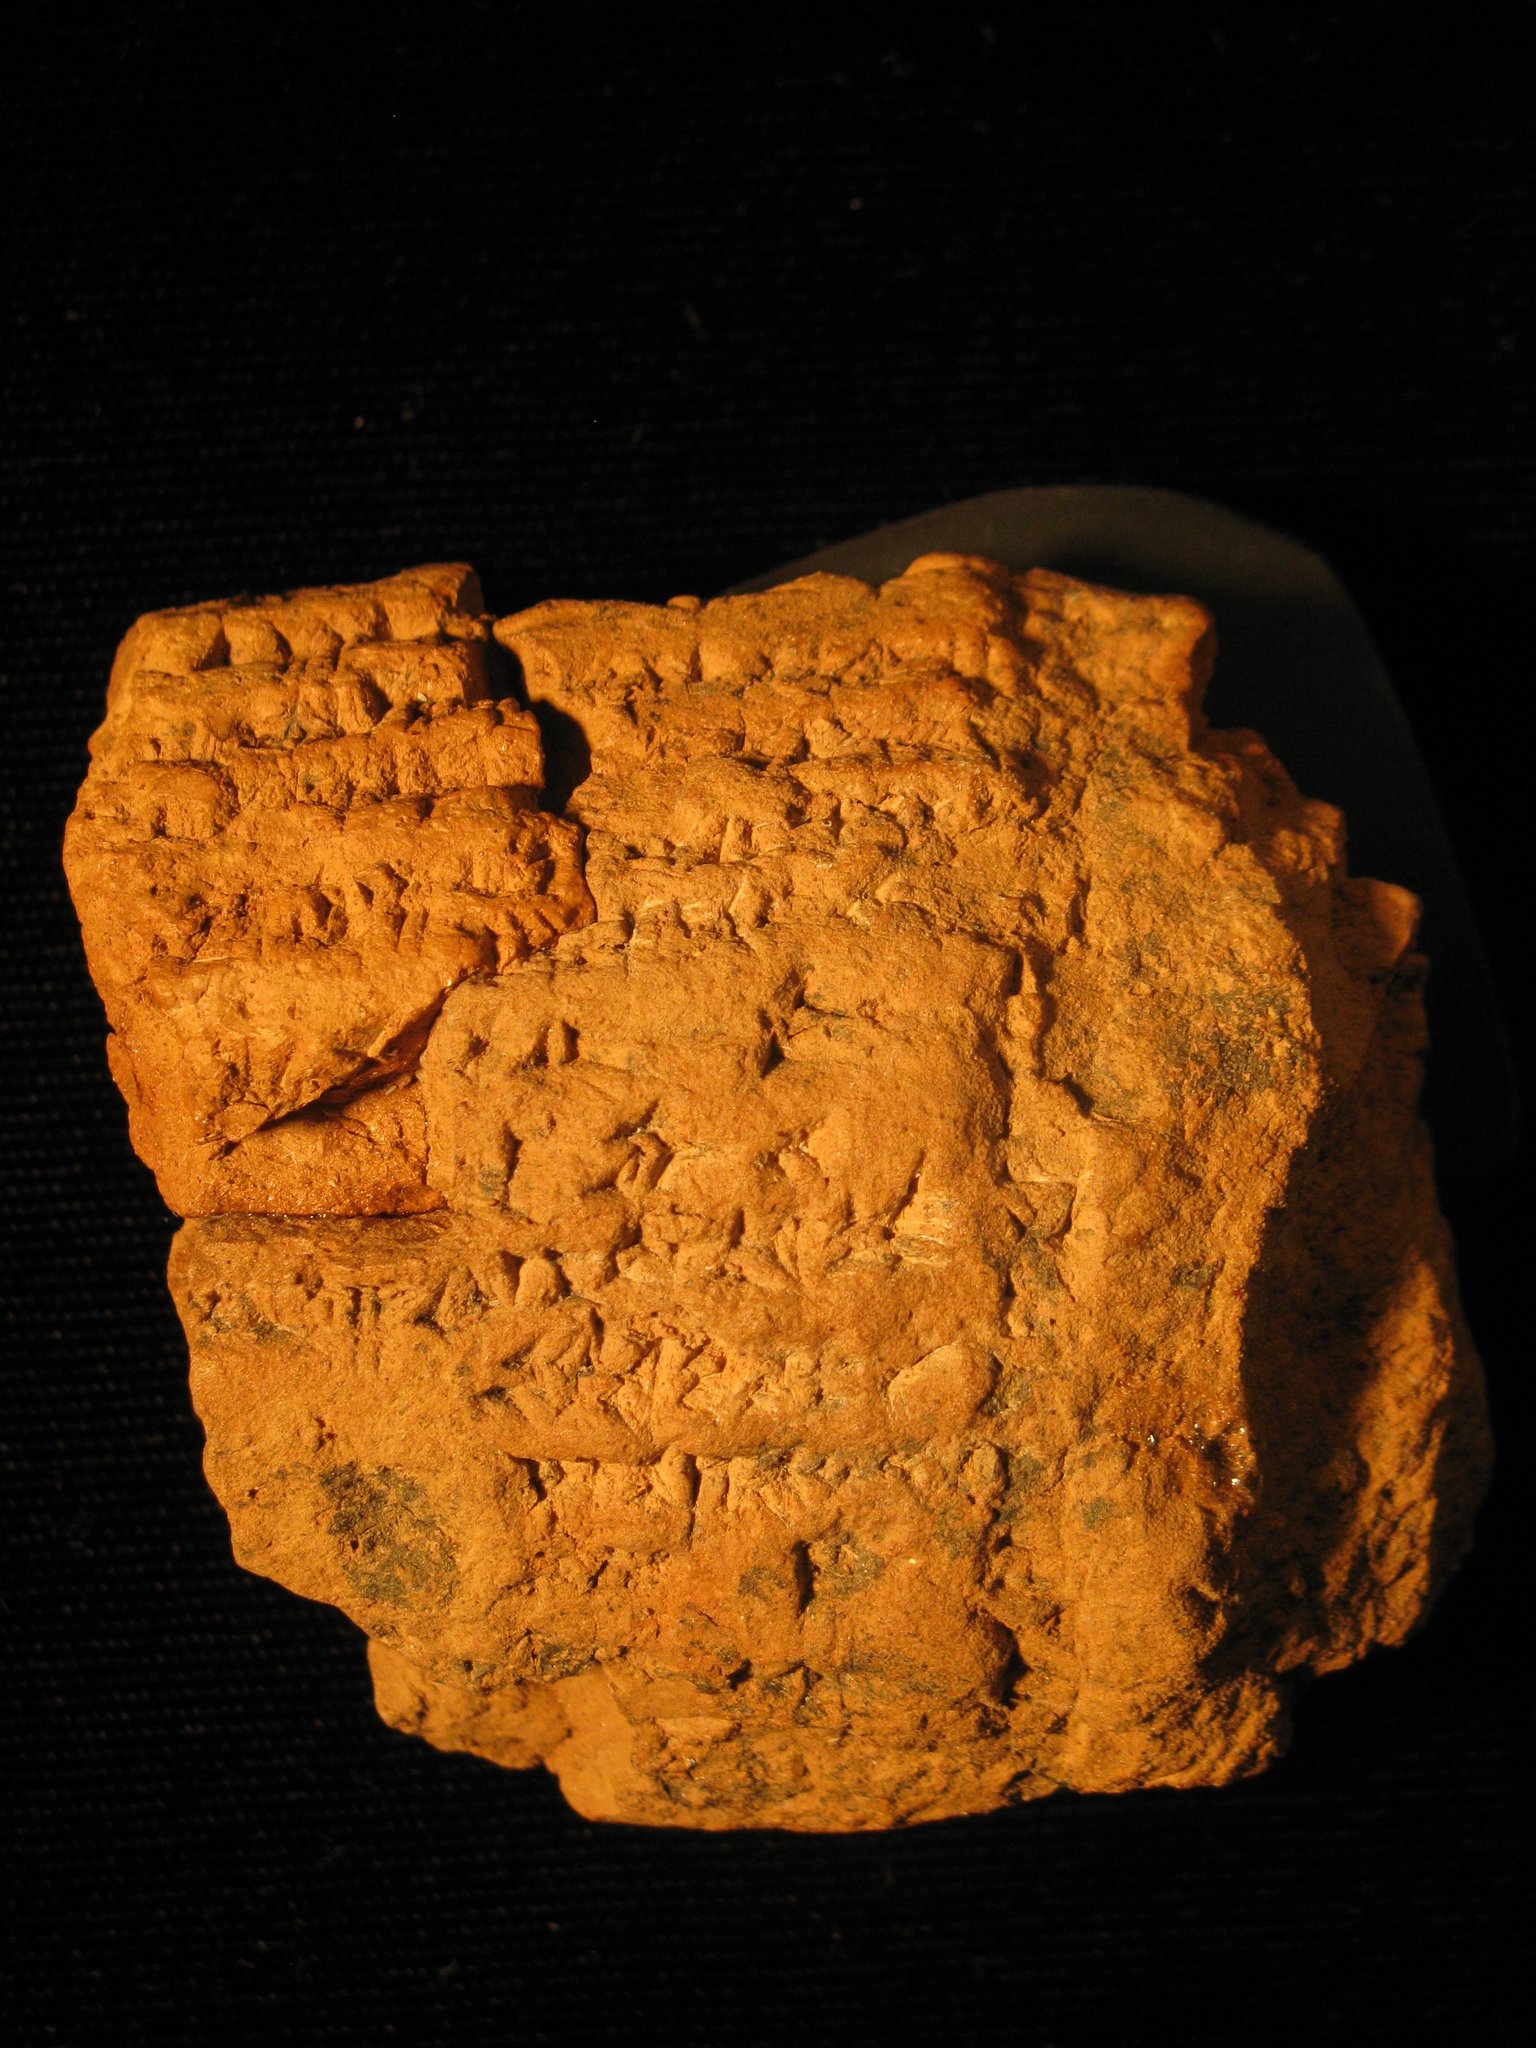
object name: cuneiform cylinder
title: Fragment of a solid clay barrel cylinder inscribed with an unidentified hymn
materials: clay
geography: mesopotamia